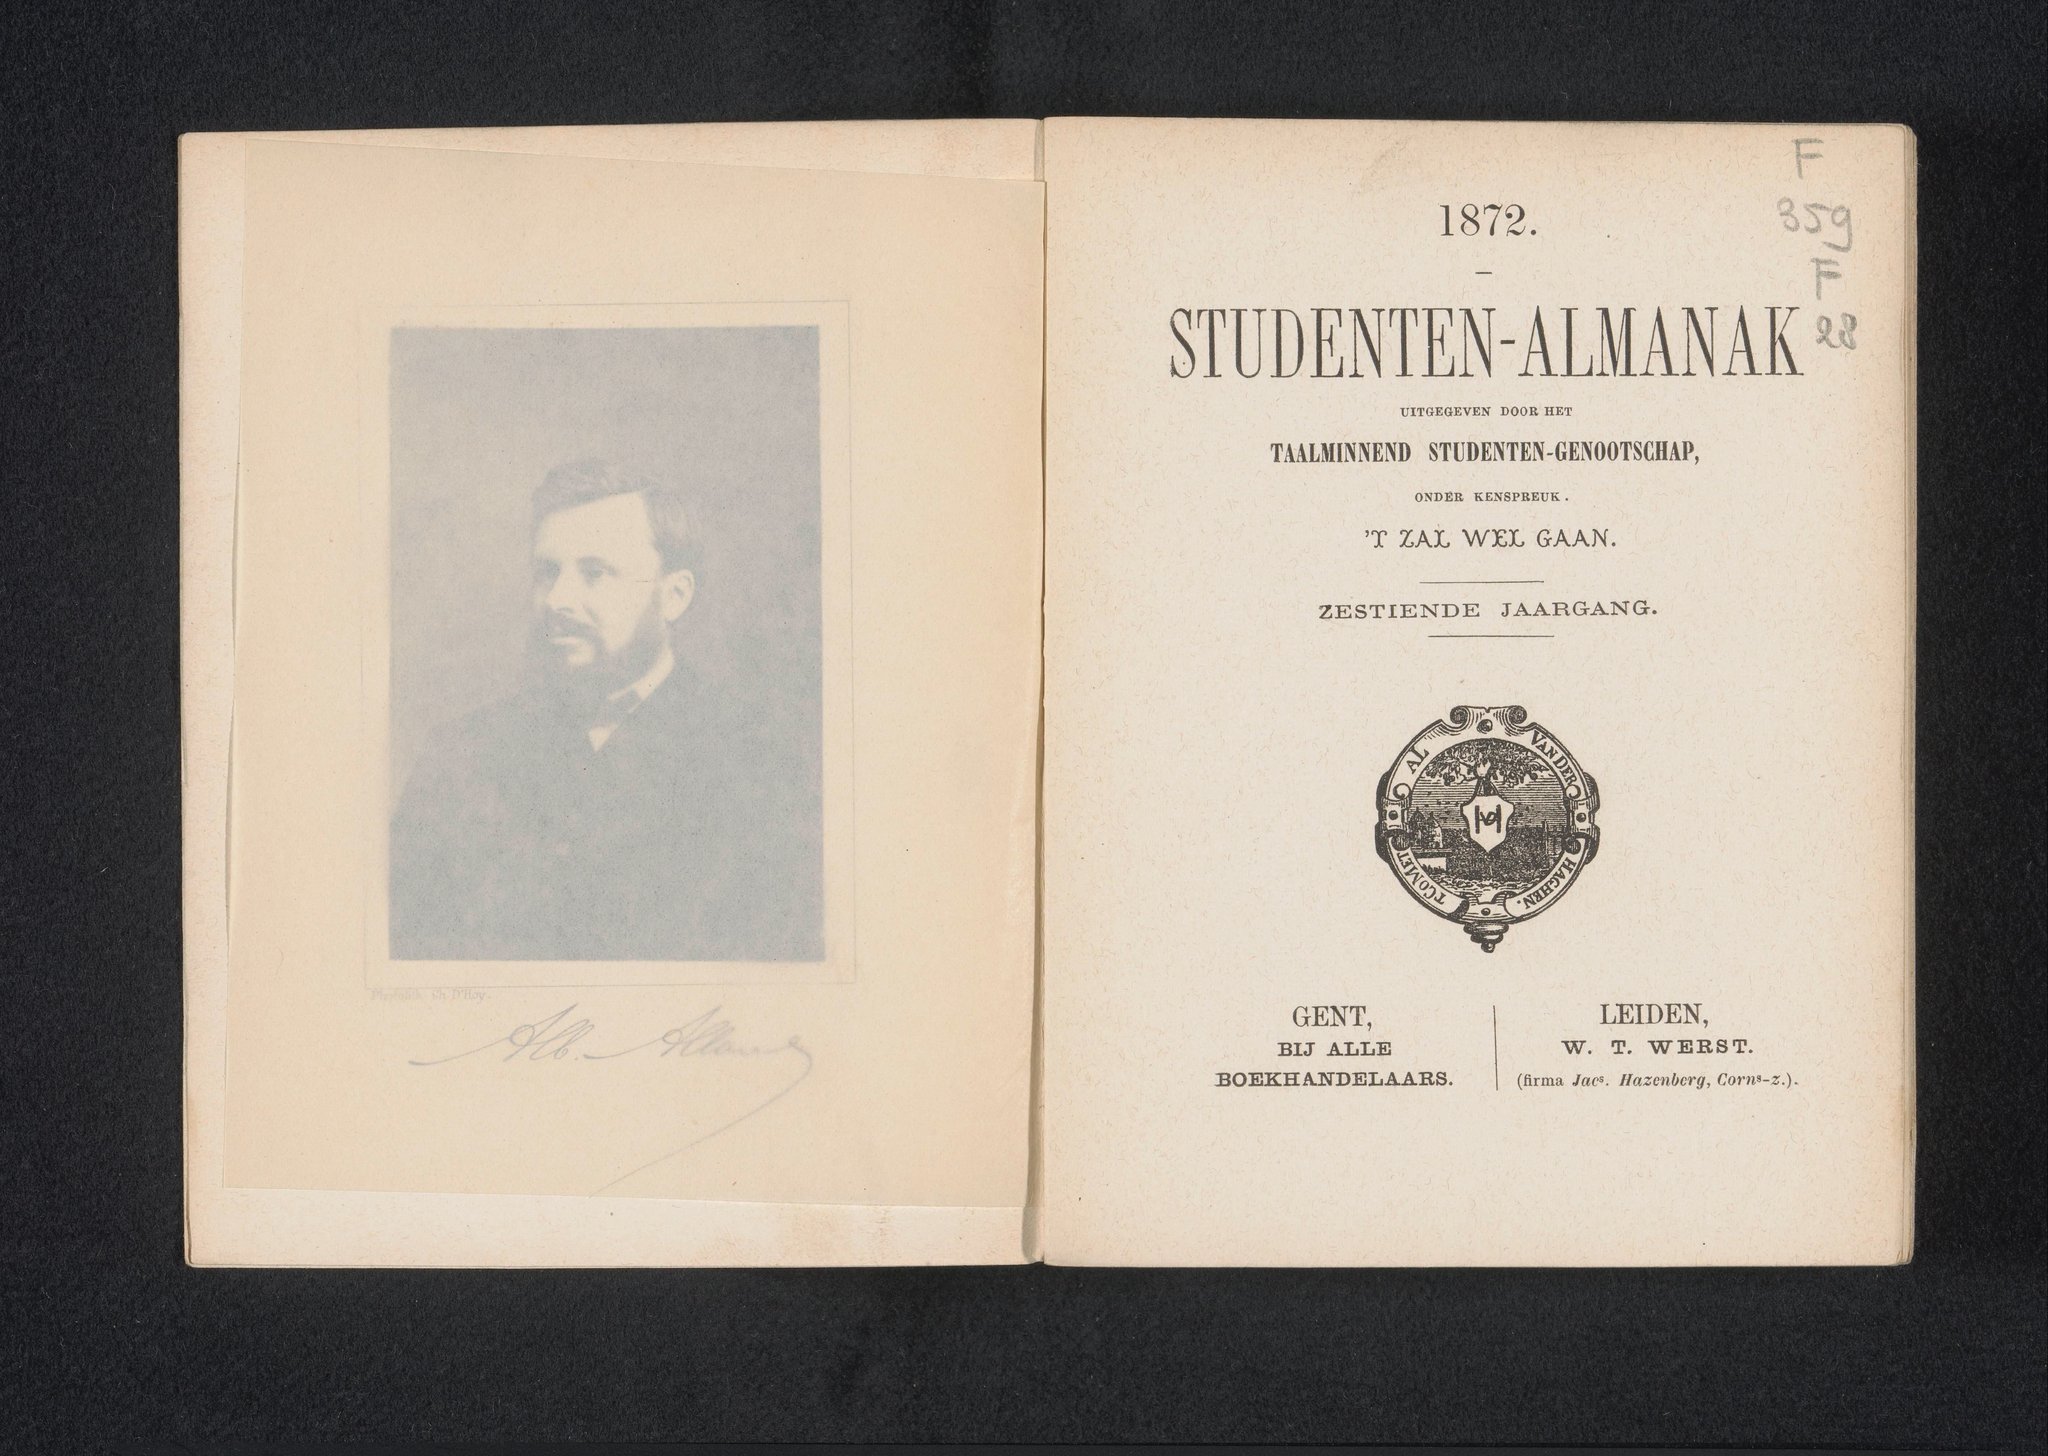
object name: book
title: Studenten-almanak uitgegeven door het Taalminnend Studenten-Genootschap, onder kenspreuk: 't Zal wel gaan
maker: w.t. werst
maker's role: publisher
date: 1872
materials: cardboard, paper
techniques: photograph, printing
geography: leiden